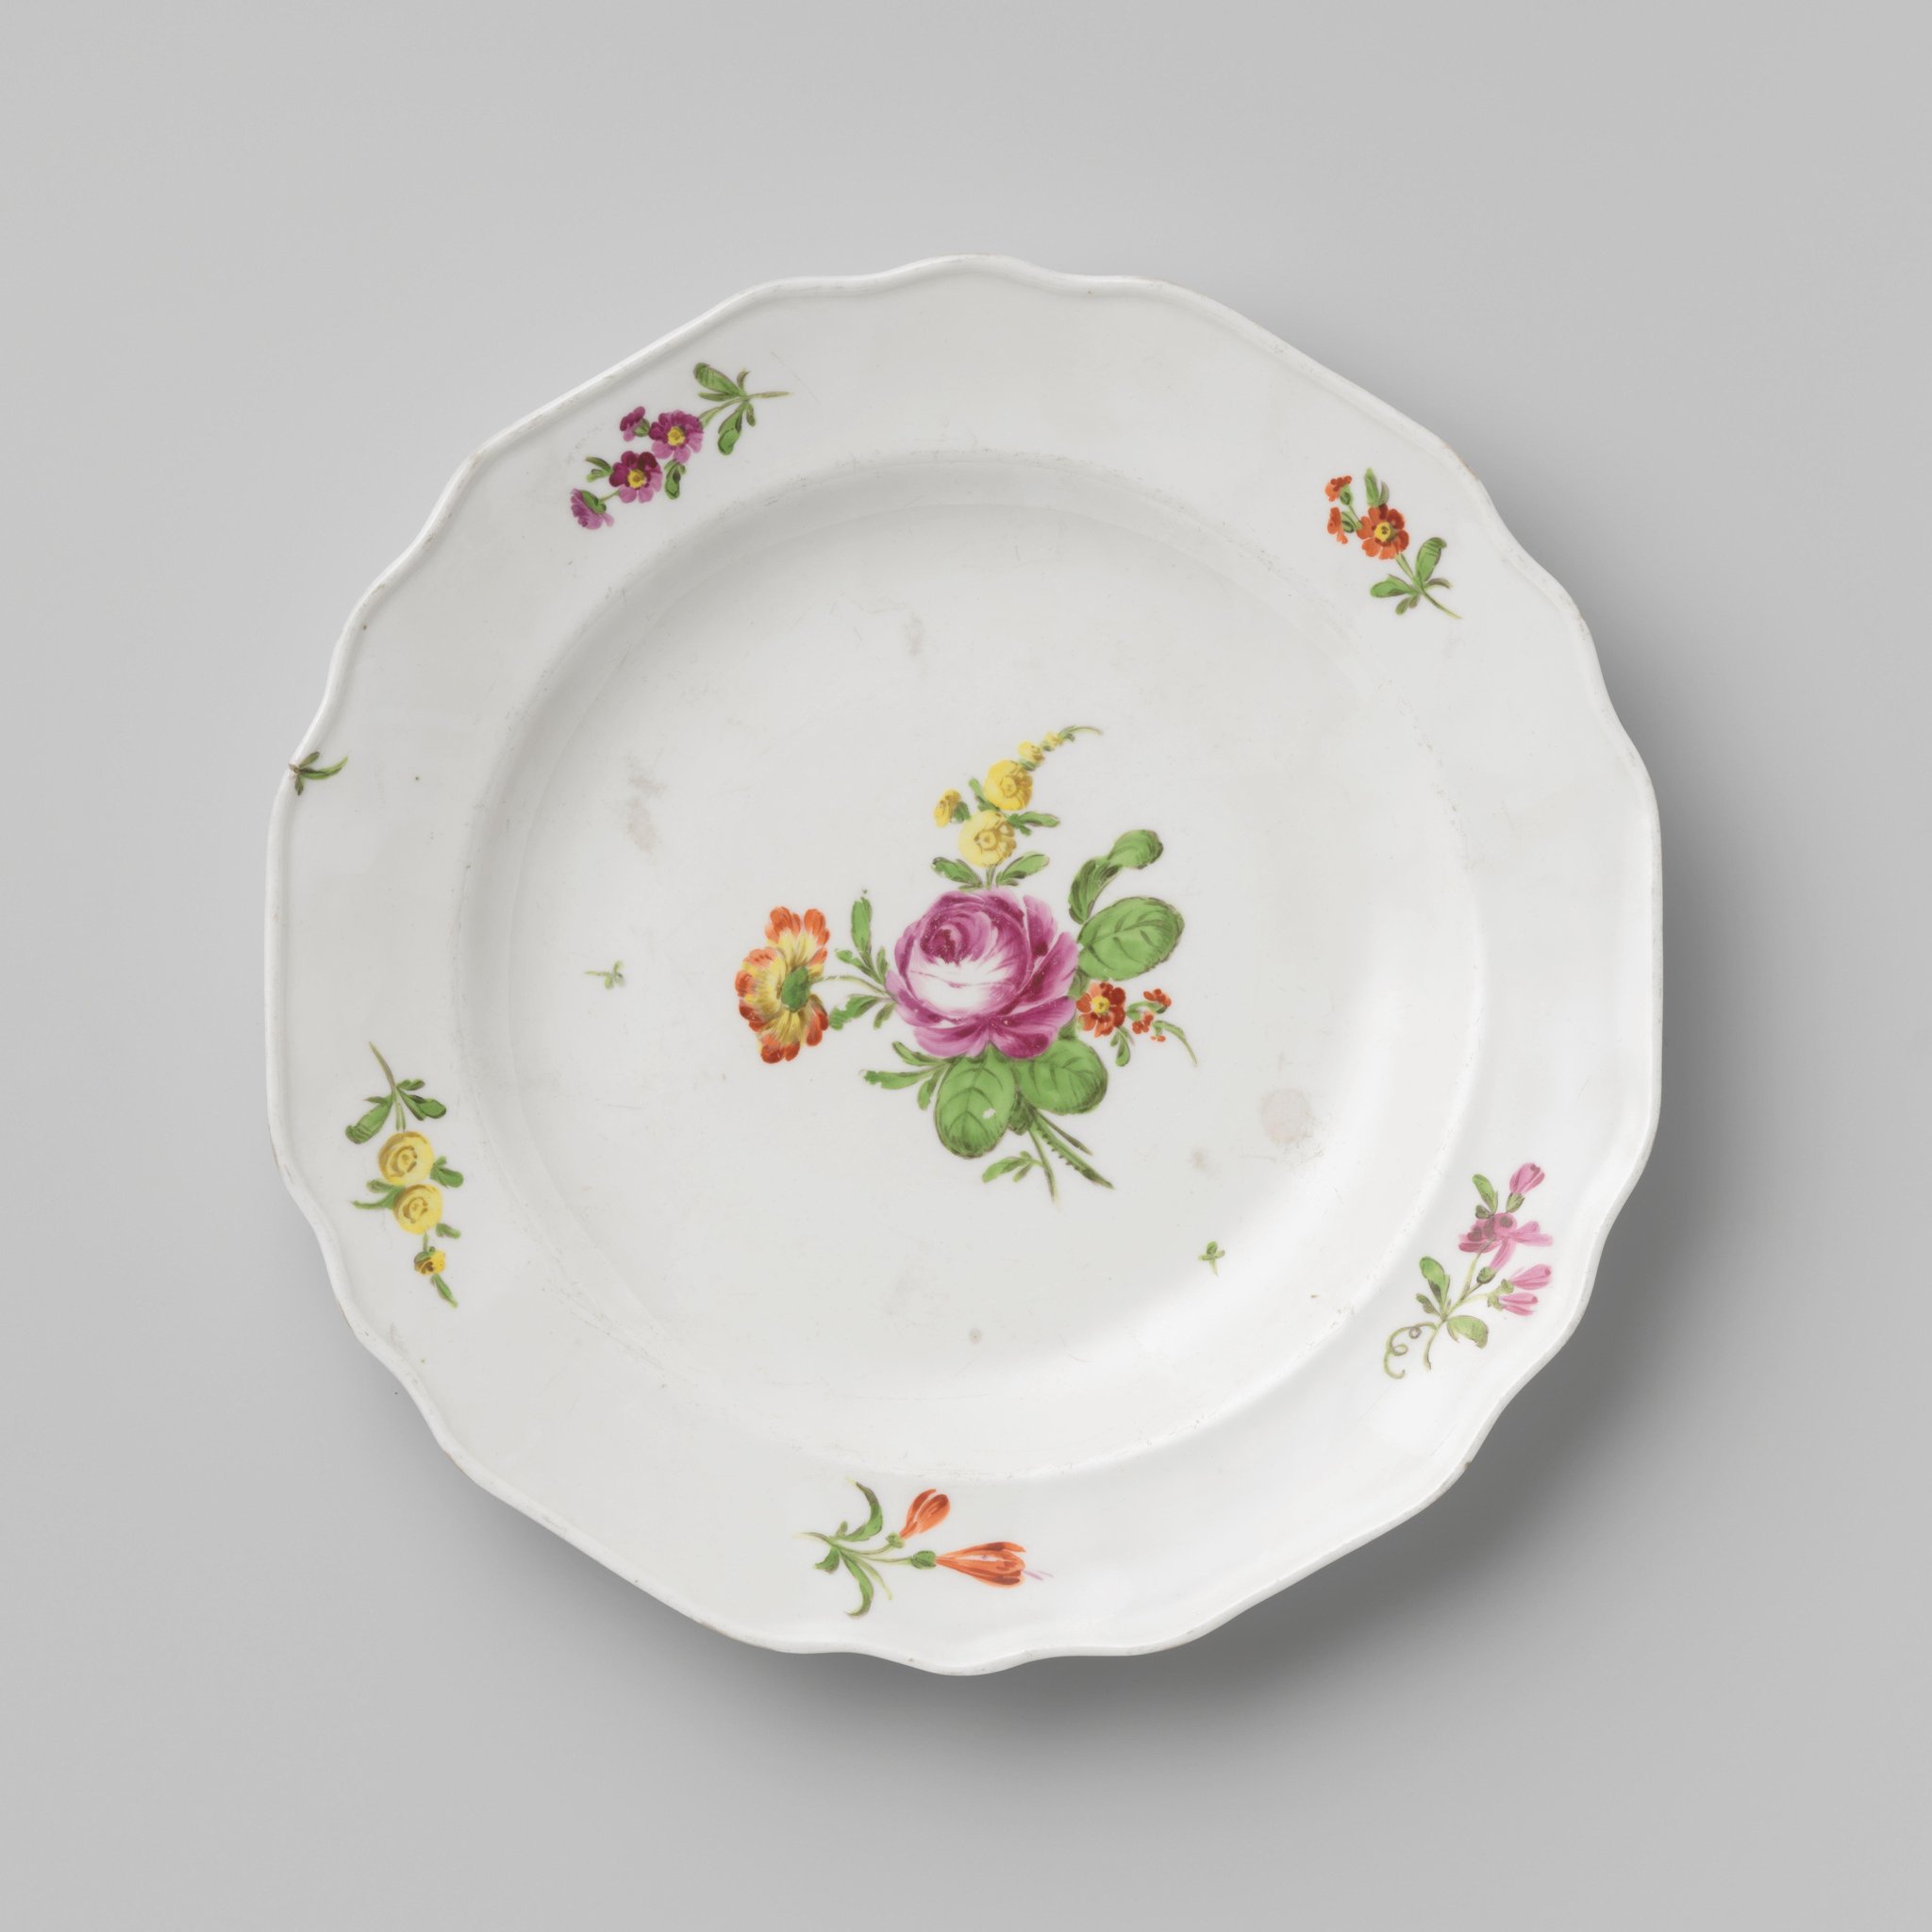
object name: plate dish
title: Plate with a bouquet and flower sprays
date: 1800-1849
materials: glaze, paint, porcelain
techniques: firing, forming, turning, vitrification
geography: vienna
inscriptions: mark: ‘schild/ P[?]/ 40/ 88/ I’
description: Bord van porselein met een gelobde rand, beschilderd op het glazuur in rood, roze, groen en geel. Op het plat een boeket van verschillende bloemen (o.a. pioenroos) omgeven door losse takjes en op de rand vijf bloemtakken. Gemerkt op de onderzijde met het schild, de letter P[?], de nummers 40, 88 en I.